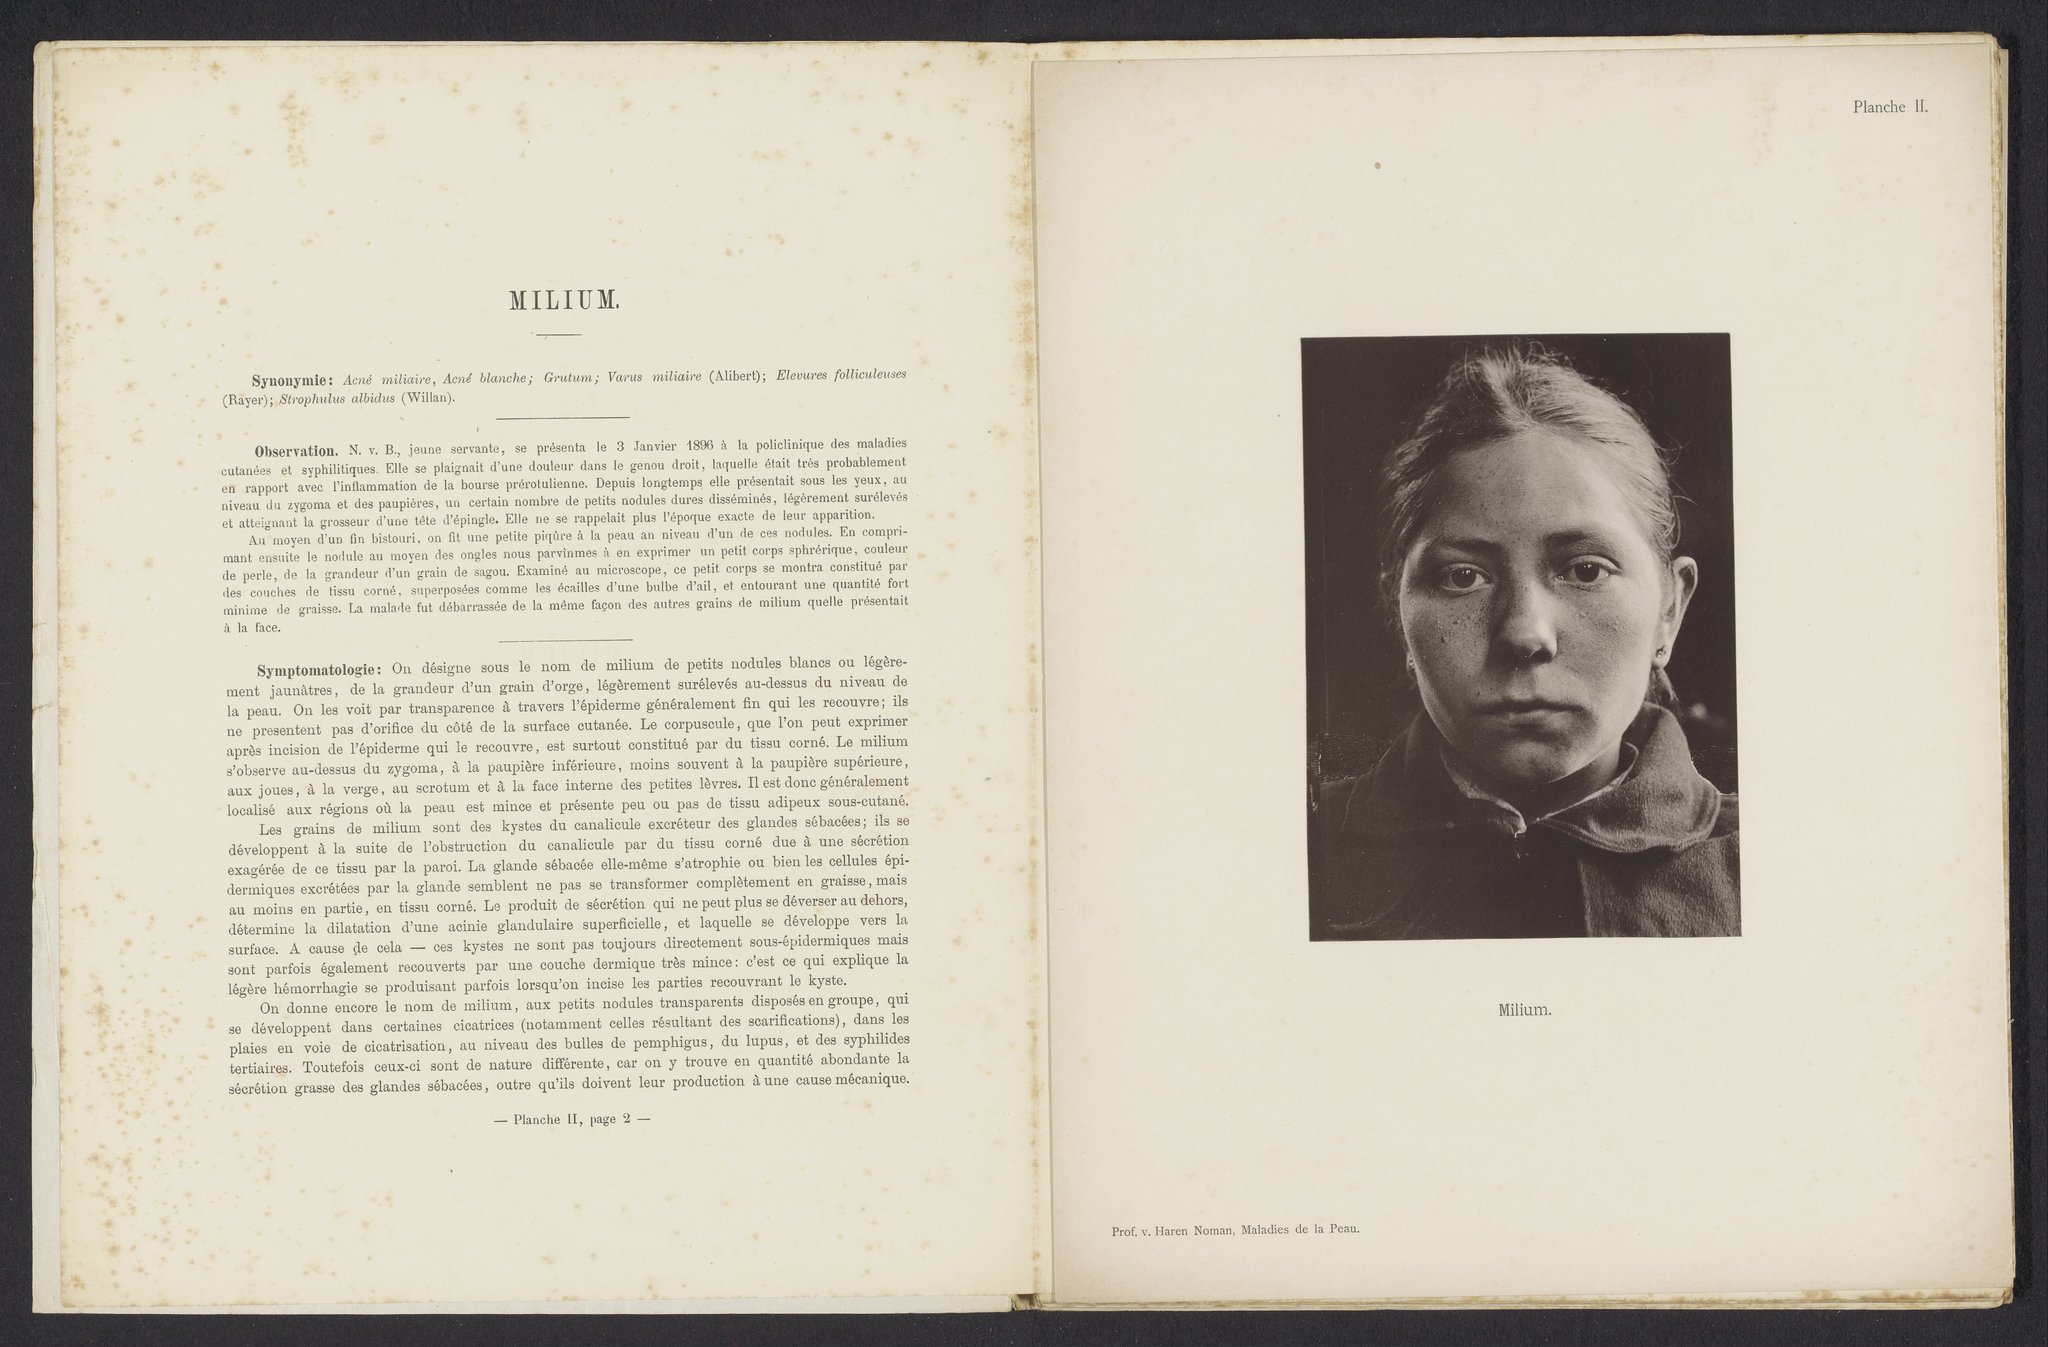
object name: photomechanical print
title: Milium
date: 1887-1897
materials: paper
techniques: photograph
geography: amsterdam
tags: face, skin and venereal diseases, child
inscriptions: number: ‘Planche II.’